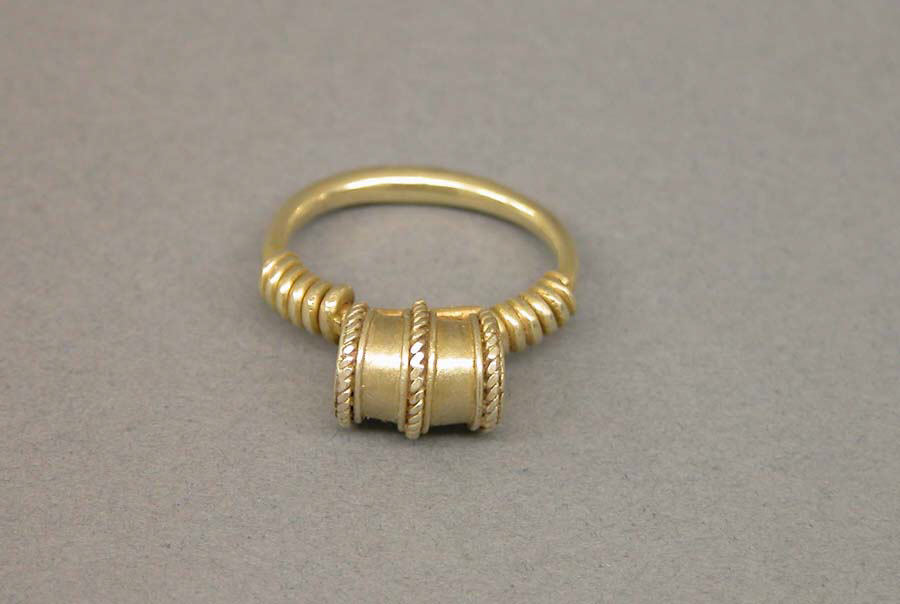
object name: ring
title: Ring with Barrel-shaped Bezel and Ribbed Hoop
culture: indonesian, javanese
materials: gold